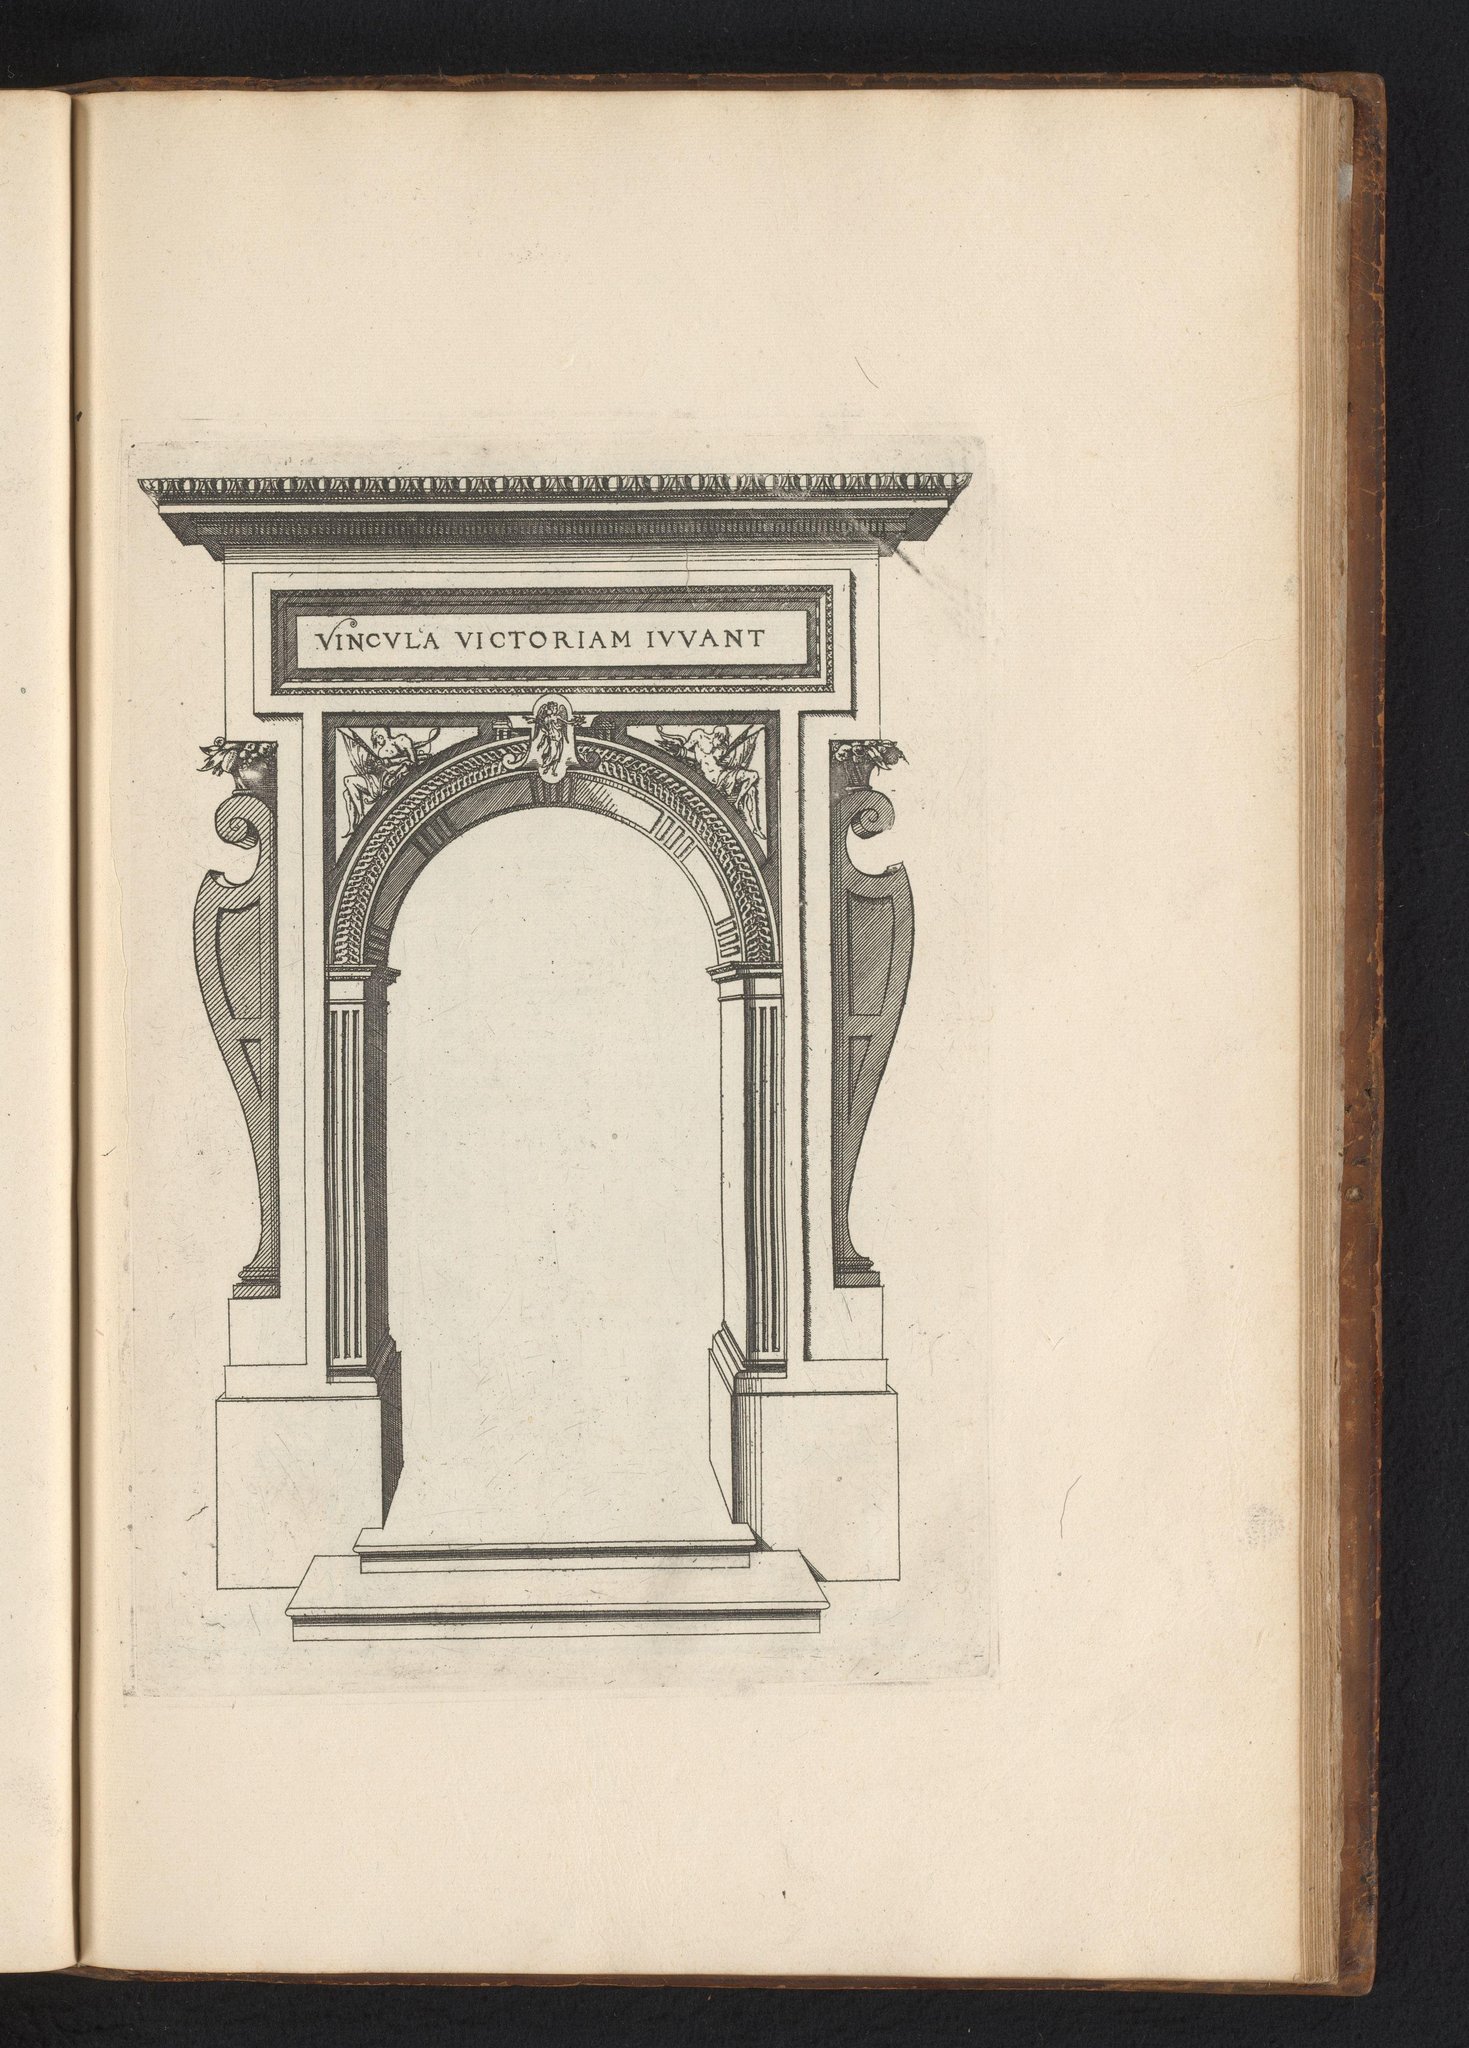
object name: ornament print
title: Poort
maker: jacques androuet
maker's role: draughtsman, print maker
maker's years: 1515-1584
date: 1561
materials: paper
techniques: etching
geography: paris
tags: architectural representations in general, arch, archivolt ~ architecture, door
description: Poort. Onderdeel van 'Seconde livre d'architectvre' (1561): 64 etsen met geornamenteerde architectuuronderdelen.